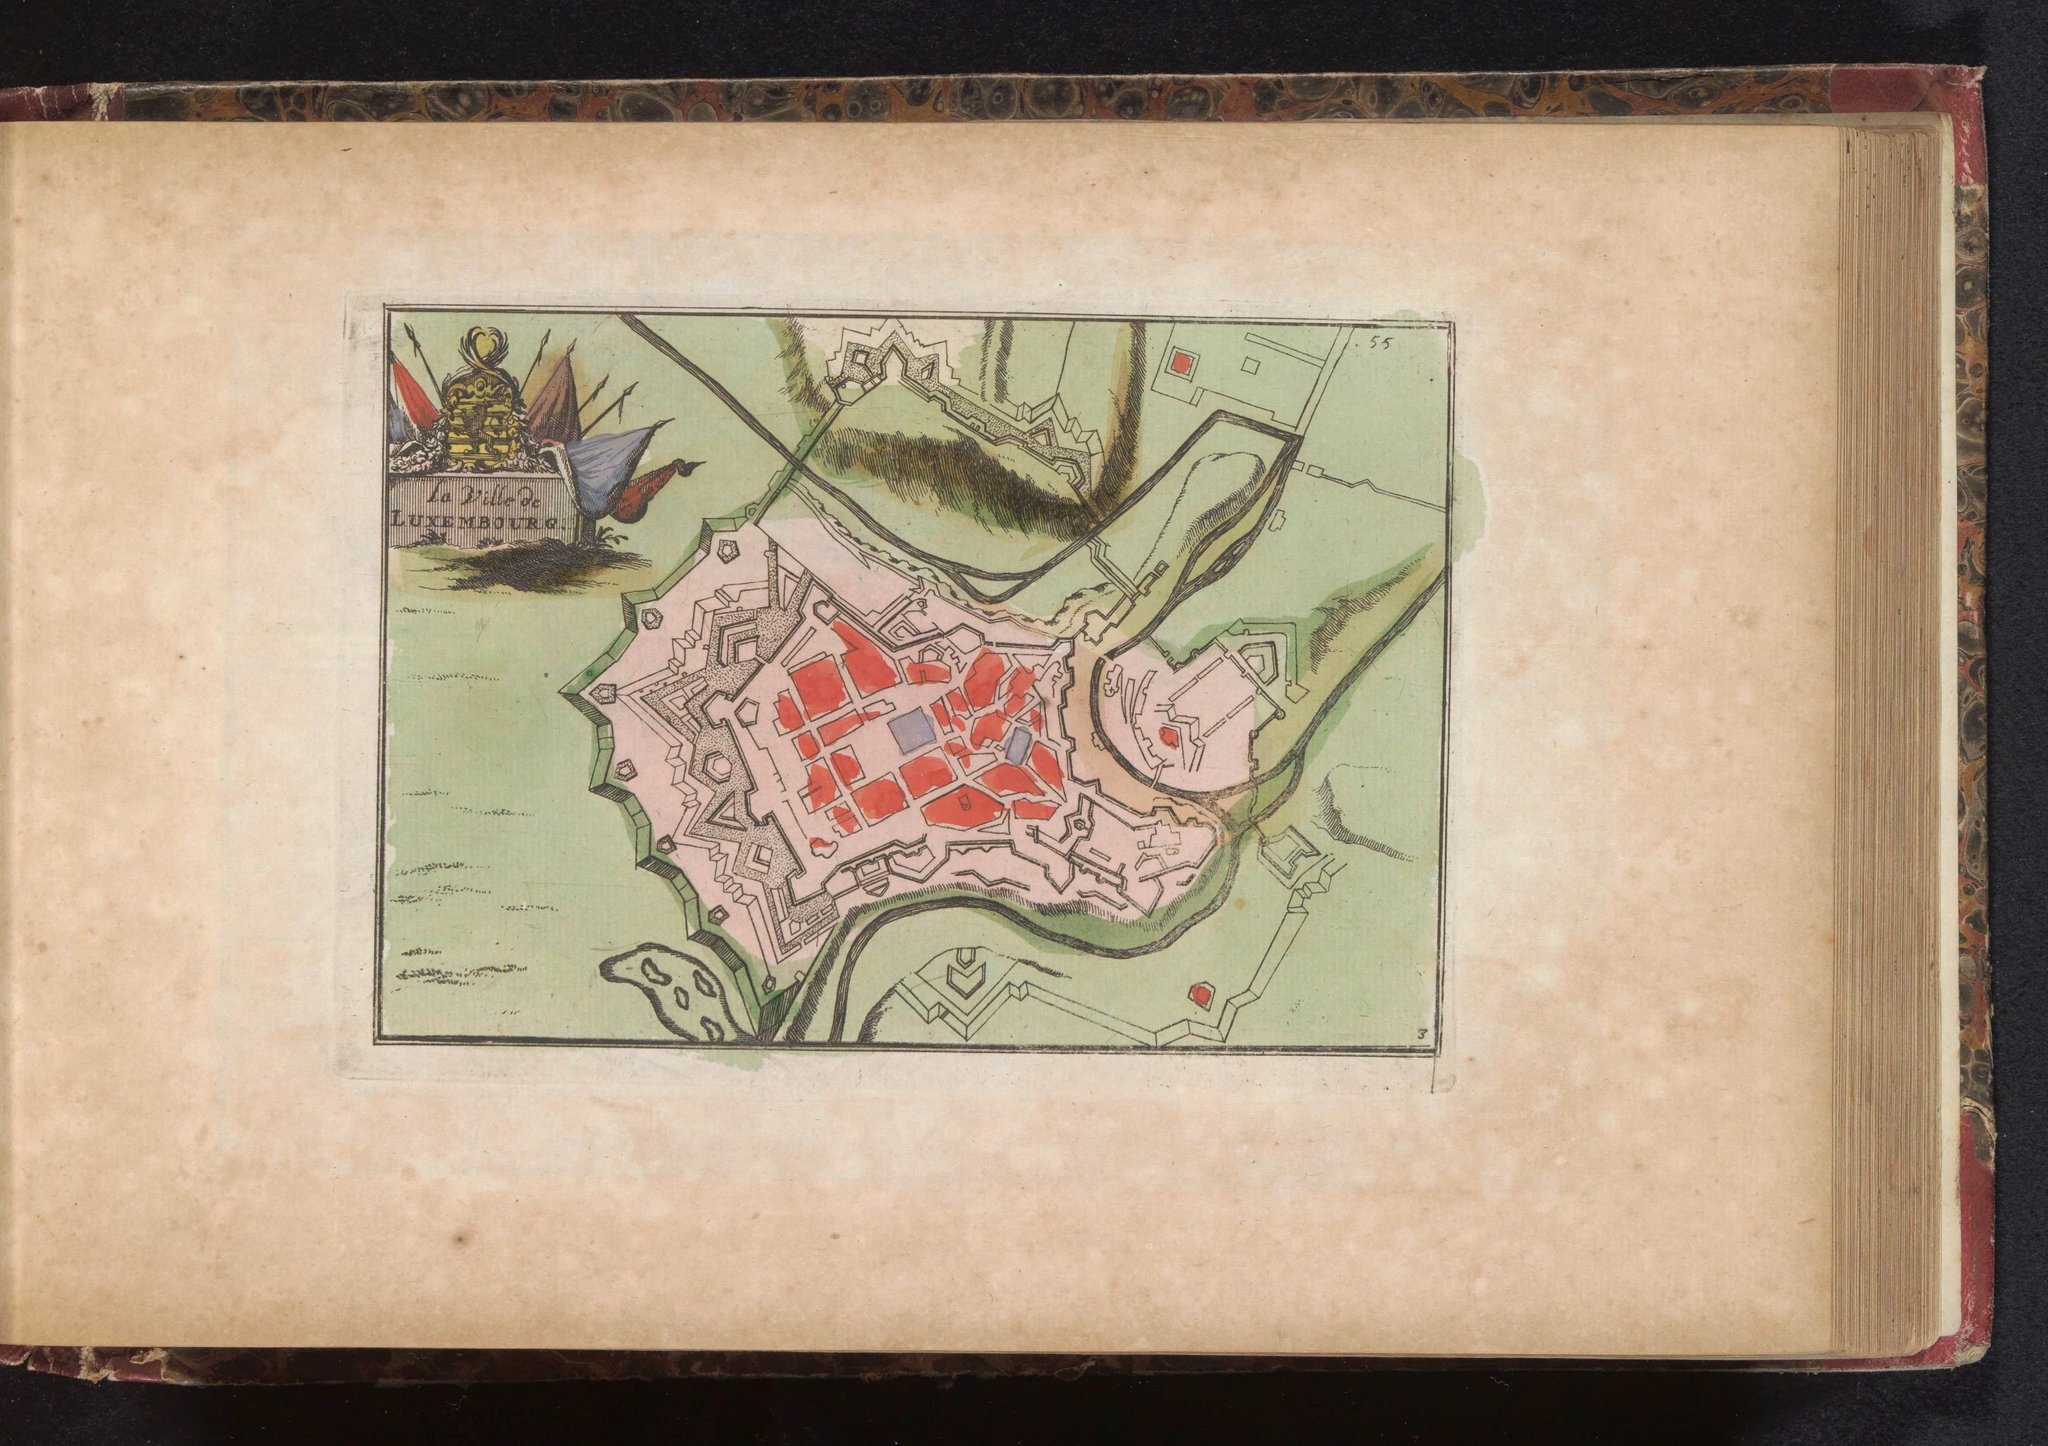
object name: map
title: La Ville de Luxembourg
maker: Anonymous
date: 1700-1702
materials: paper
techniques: etching, hand coloring, lacquer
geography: amsterdam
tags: maps of cities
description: Plattegrond van de versterkingen om de stad Luxemburg. Onderdeel van een atlas met 223 kaarten van landen en steden en oorlogstaferelen in Europa in de periode ca. 1690-1735.